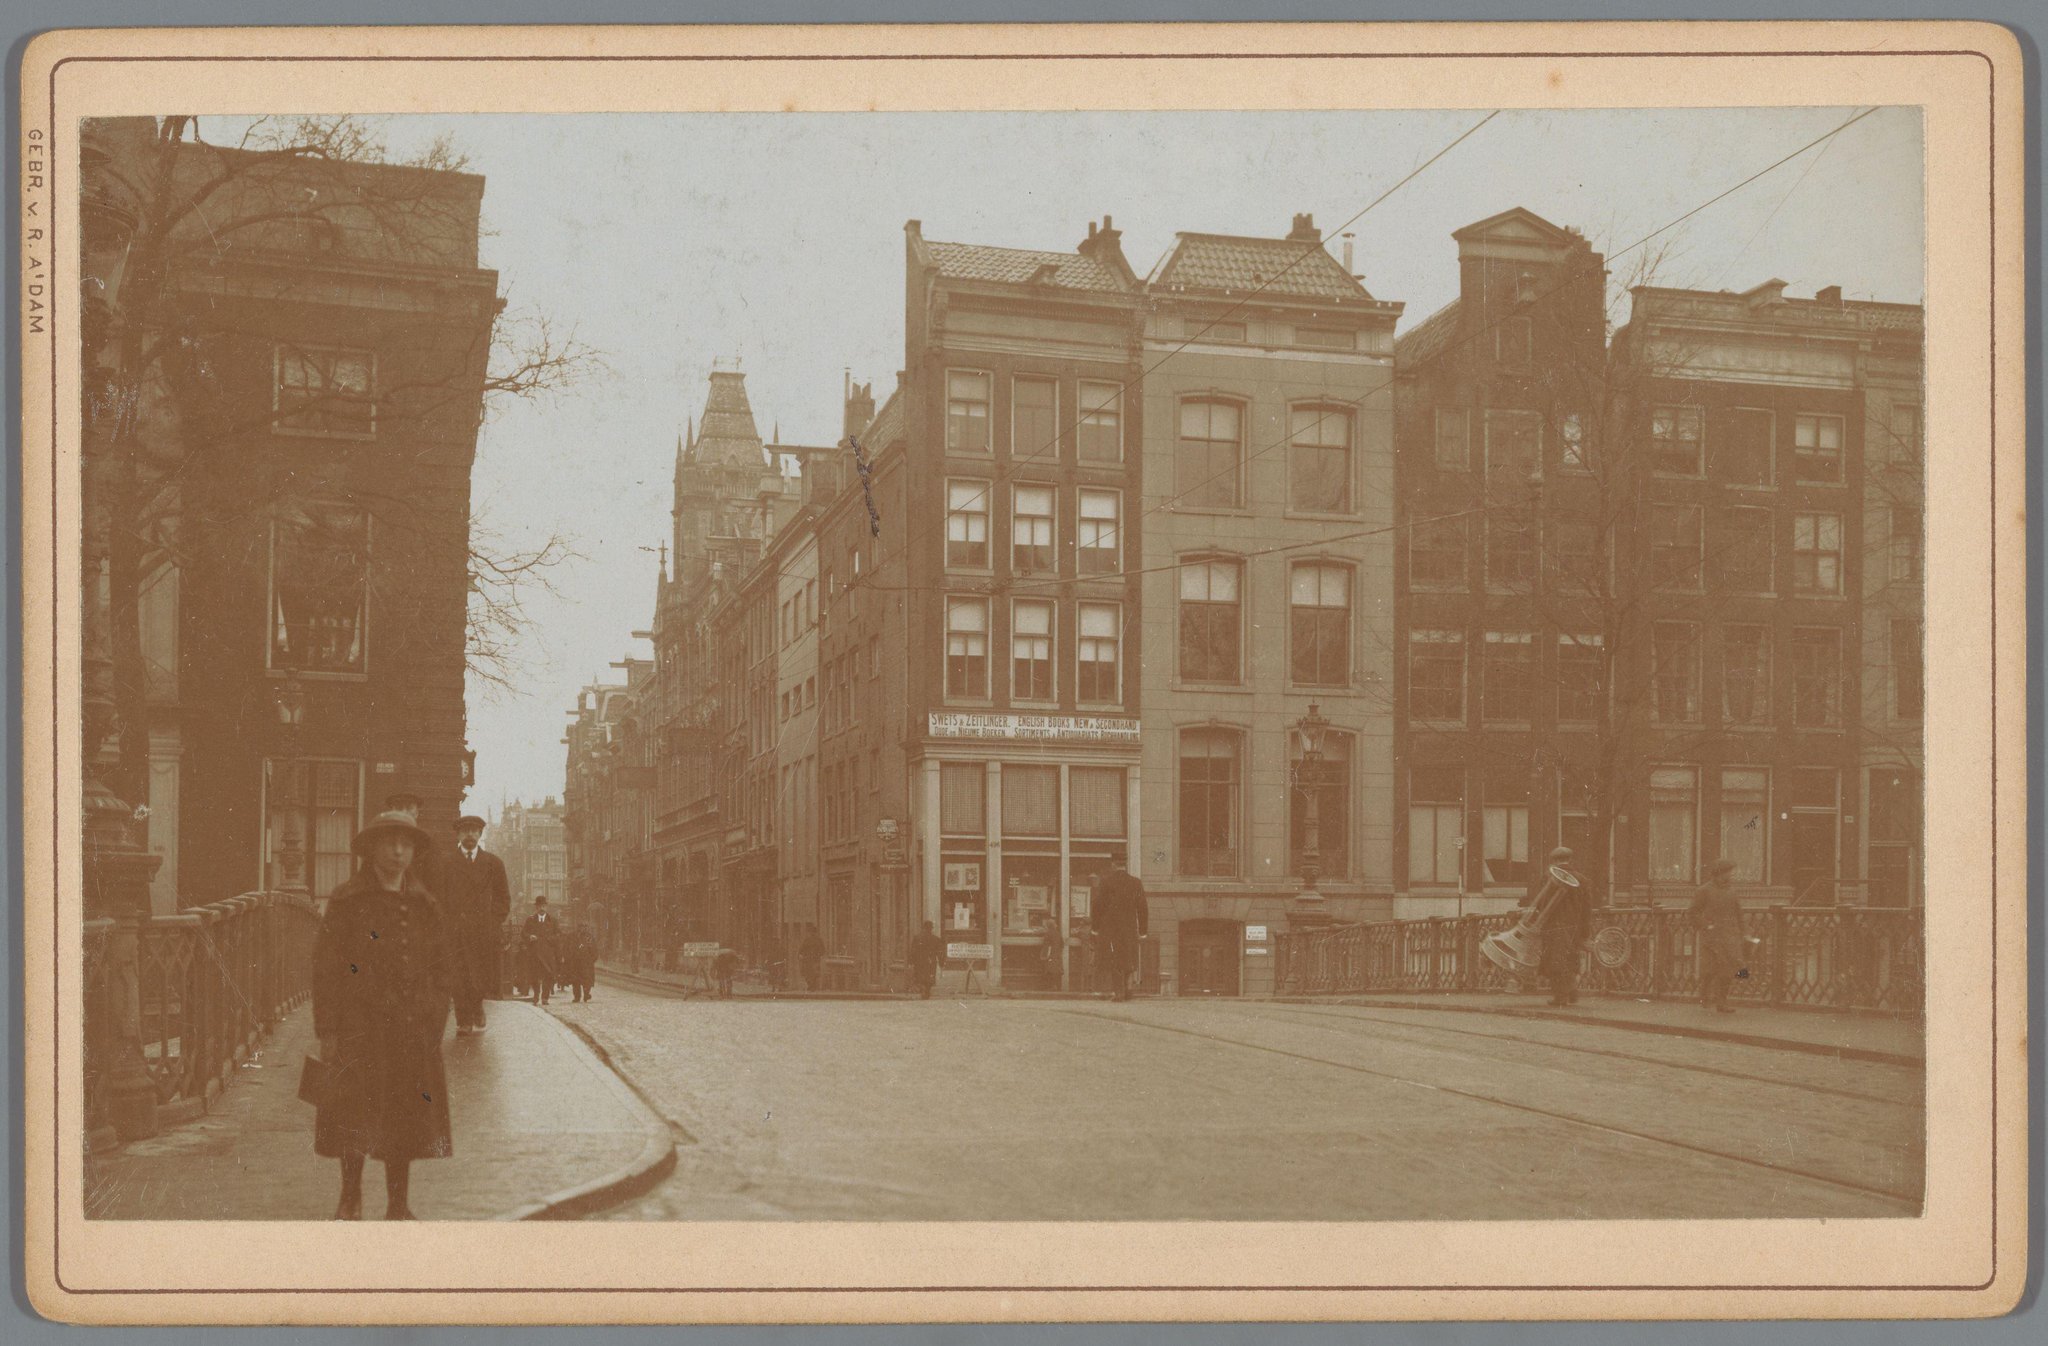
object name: cabinet photograph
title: Gezicht op de Herengracht en Vijzelstraat in Amsterdam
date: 1880-1900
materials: cardboard, photographic support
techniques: collodion silver print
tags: canals, waters (in city), the usual house or row of houses, street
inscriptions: name: ‘Vosmaer’, inscription: ‘Oude Huizen aan de Heerengracht en in de Vijzelstraat. Ziende naar de Keizersgracht, allen afgebroken ter verbreeding van de Vijzelstraat.’